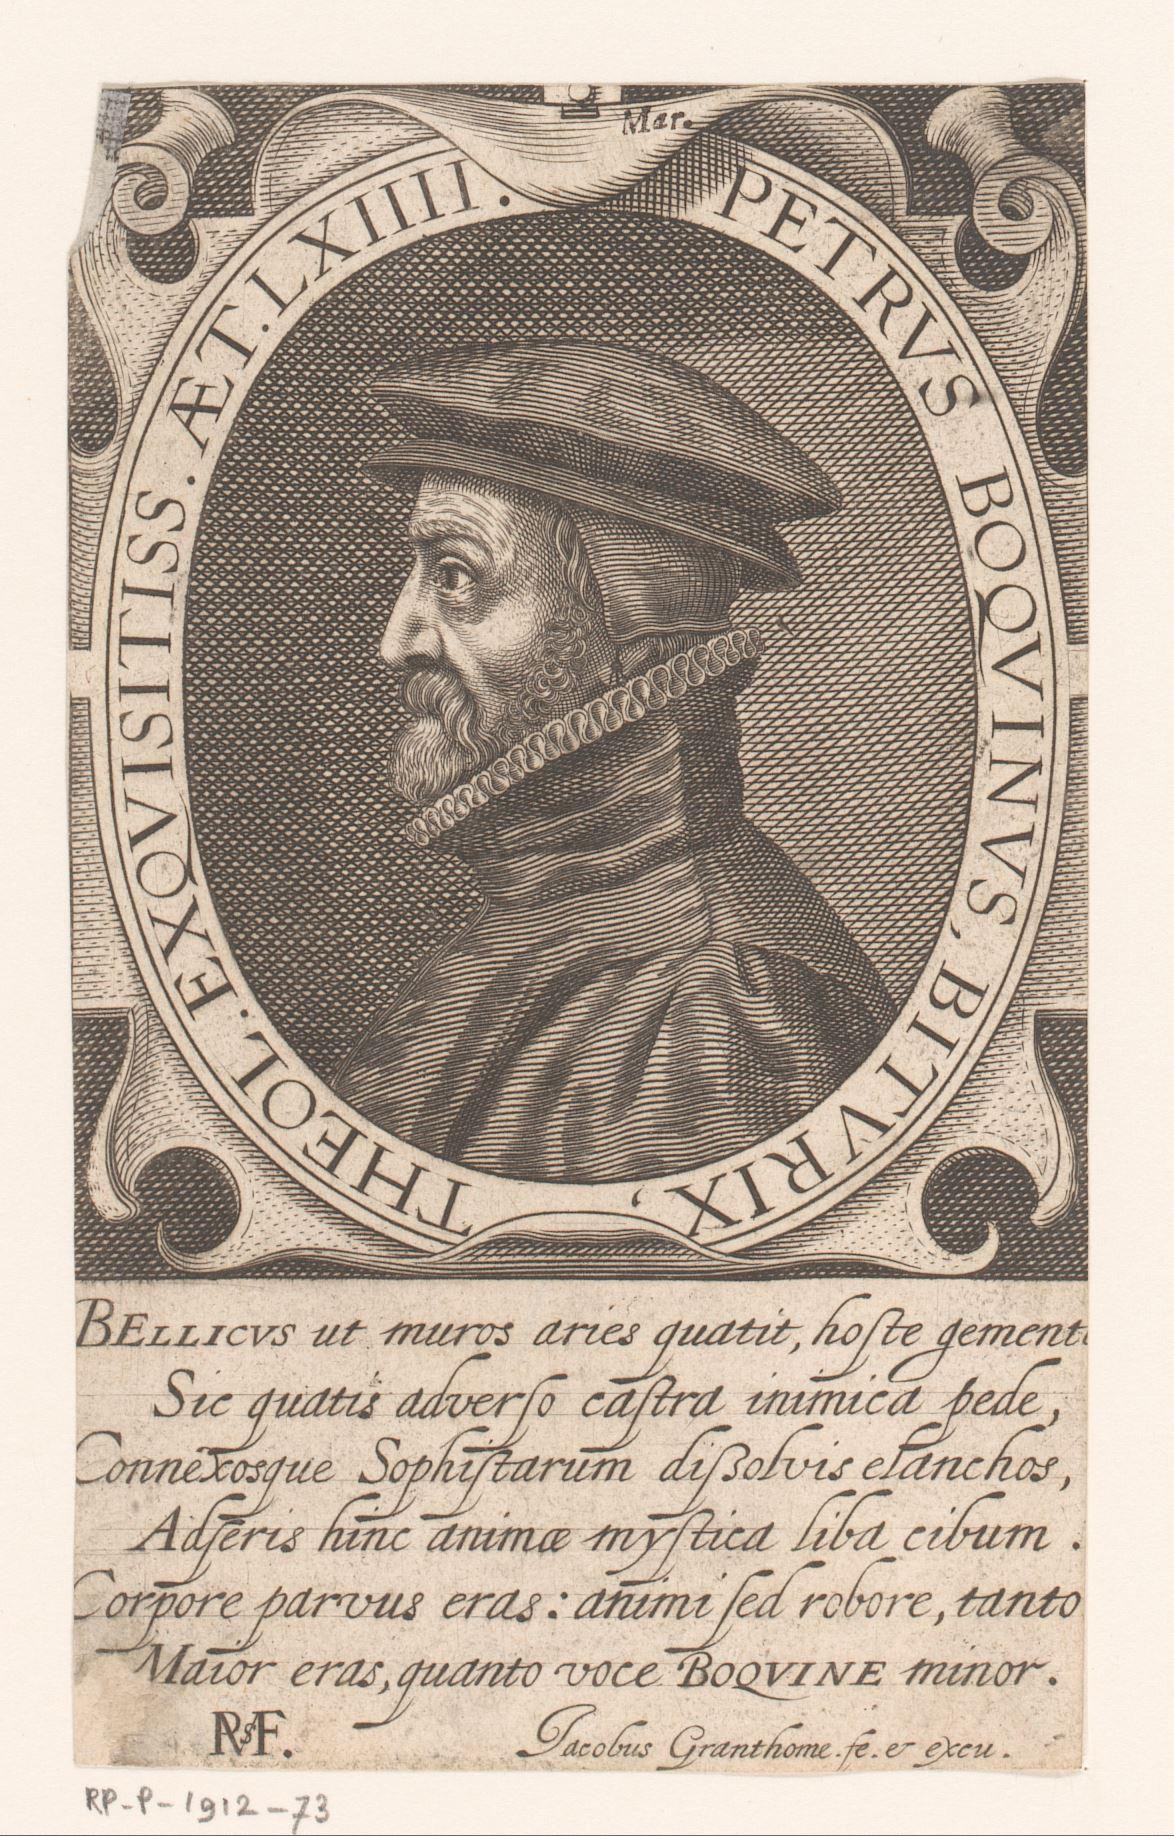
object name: print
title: Portret van Pierre Boquin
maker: jacques granthomme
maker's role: print maker, publisher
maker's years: 1550-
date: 1588-1622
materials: paper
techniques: engraving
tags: theologian, historical persons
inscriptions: collector's mark: Lugt 2228